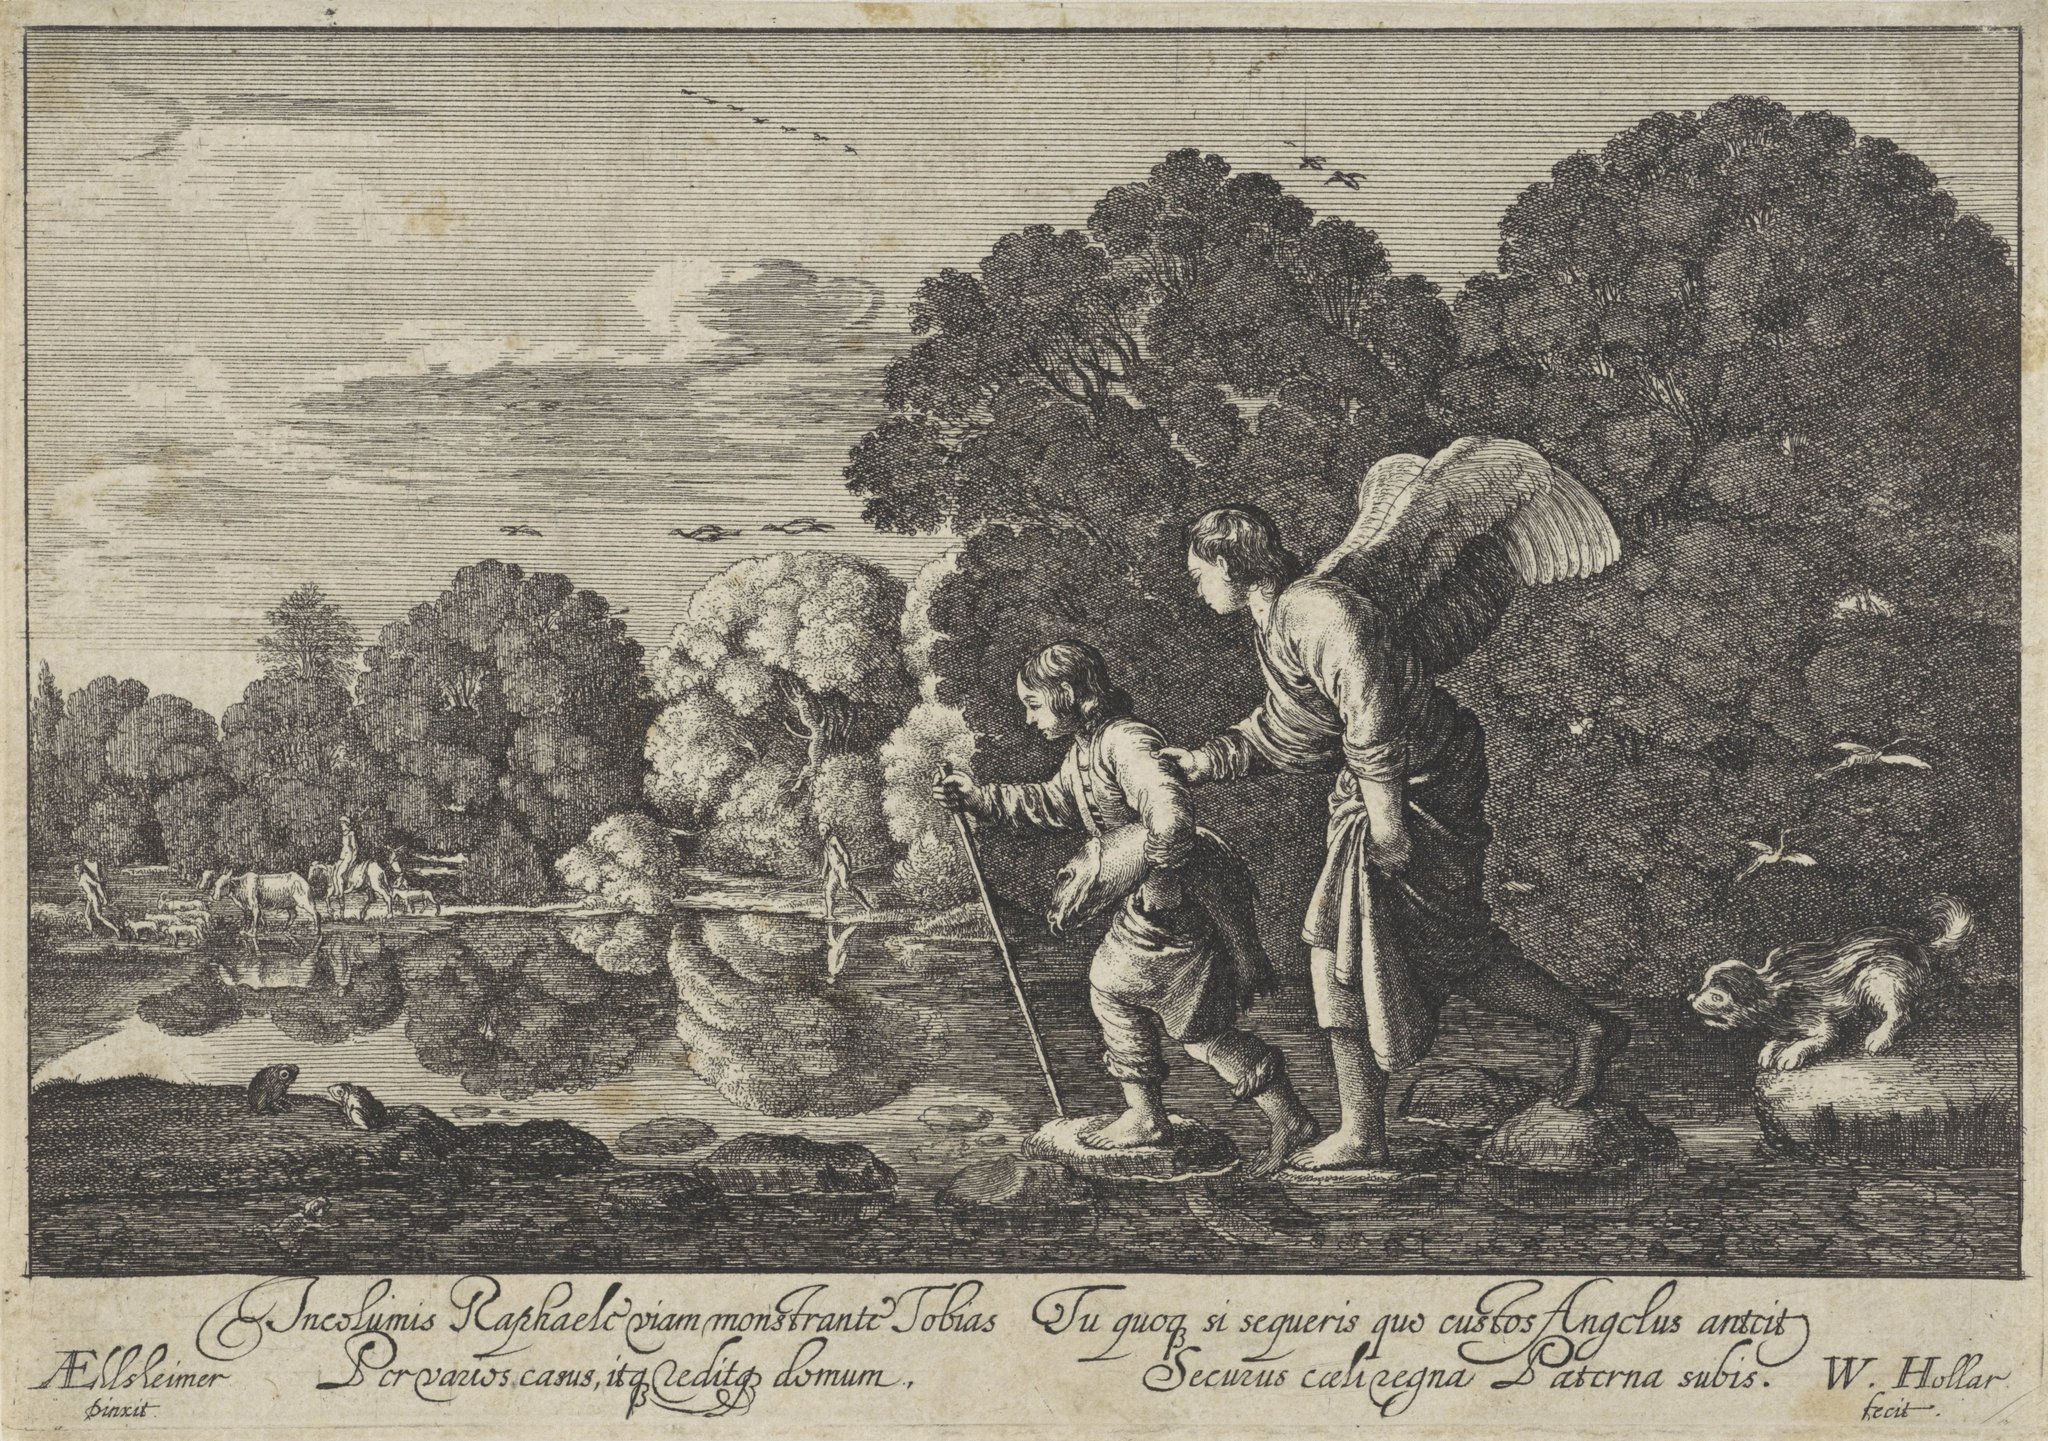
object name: print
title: Tobias en de engel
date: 1644-1652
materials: paper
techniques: etching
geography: antwerp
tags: tobias and the angel raphael travelling, accompanied by tobias' dog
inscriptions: collector's mark: Lugt 240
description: Tobias doorwaadt met een vis onder zijn arm een rivier. De engel leidt hem door zijn arm vast te houden.